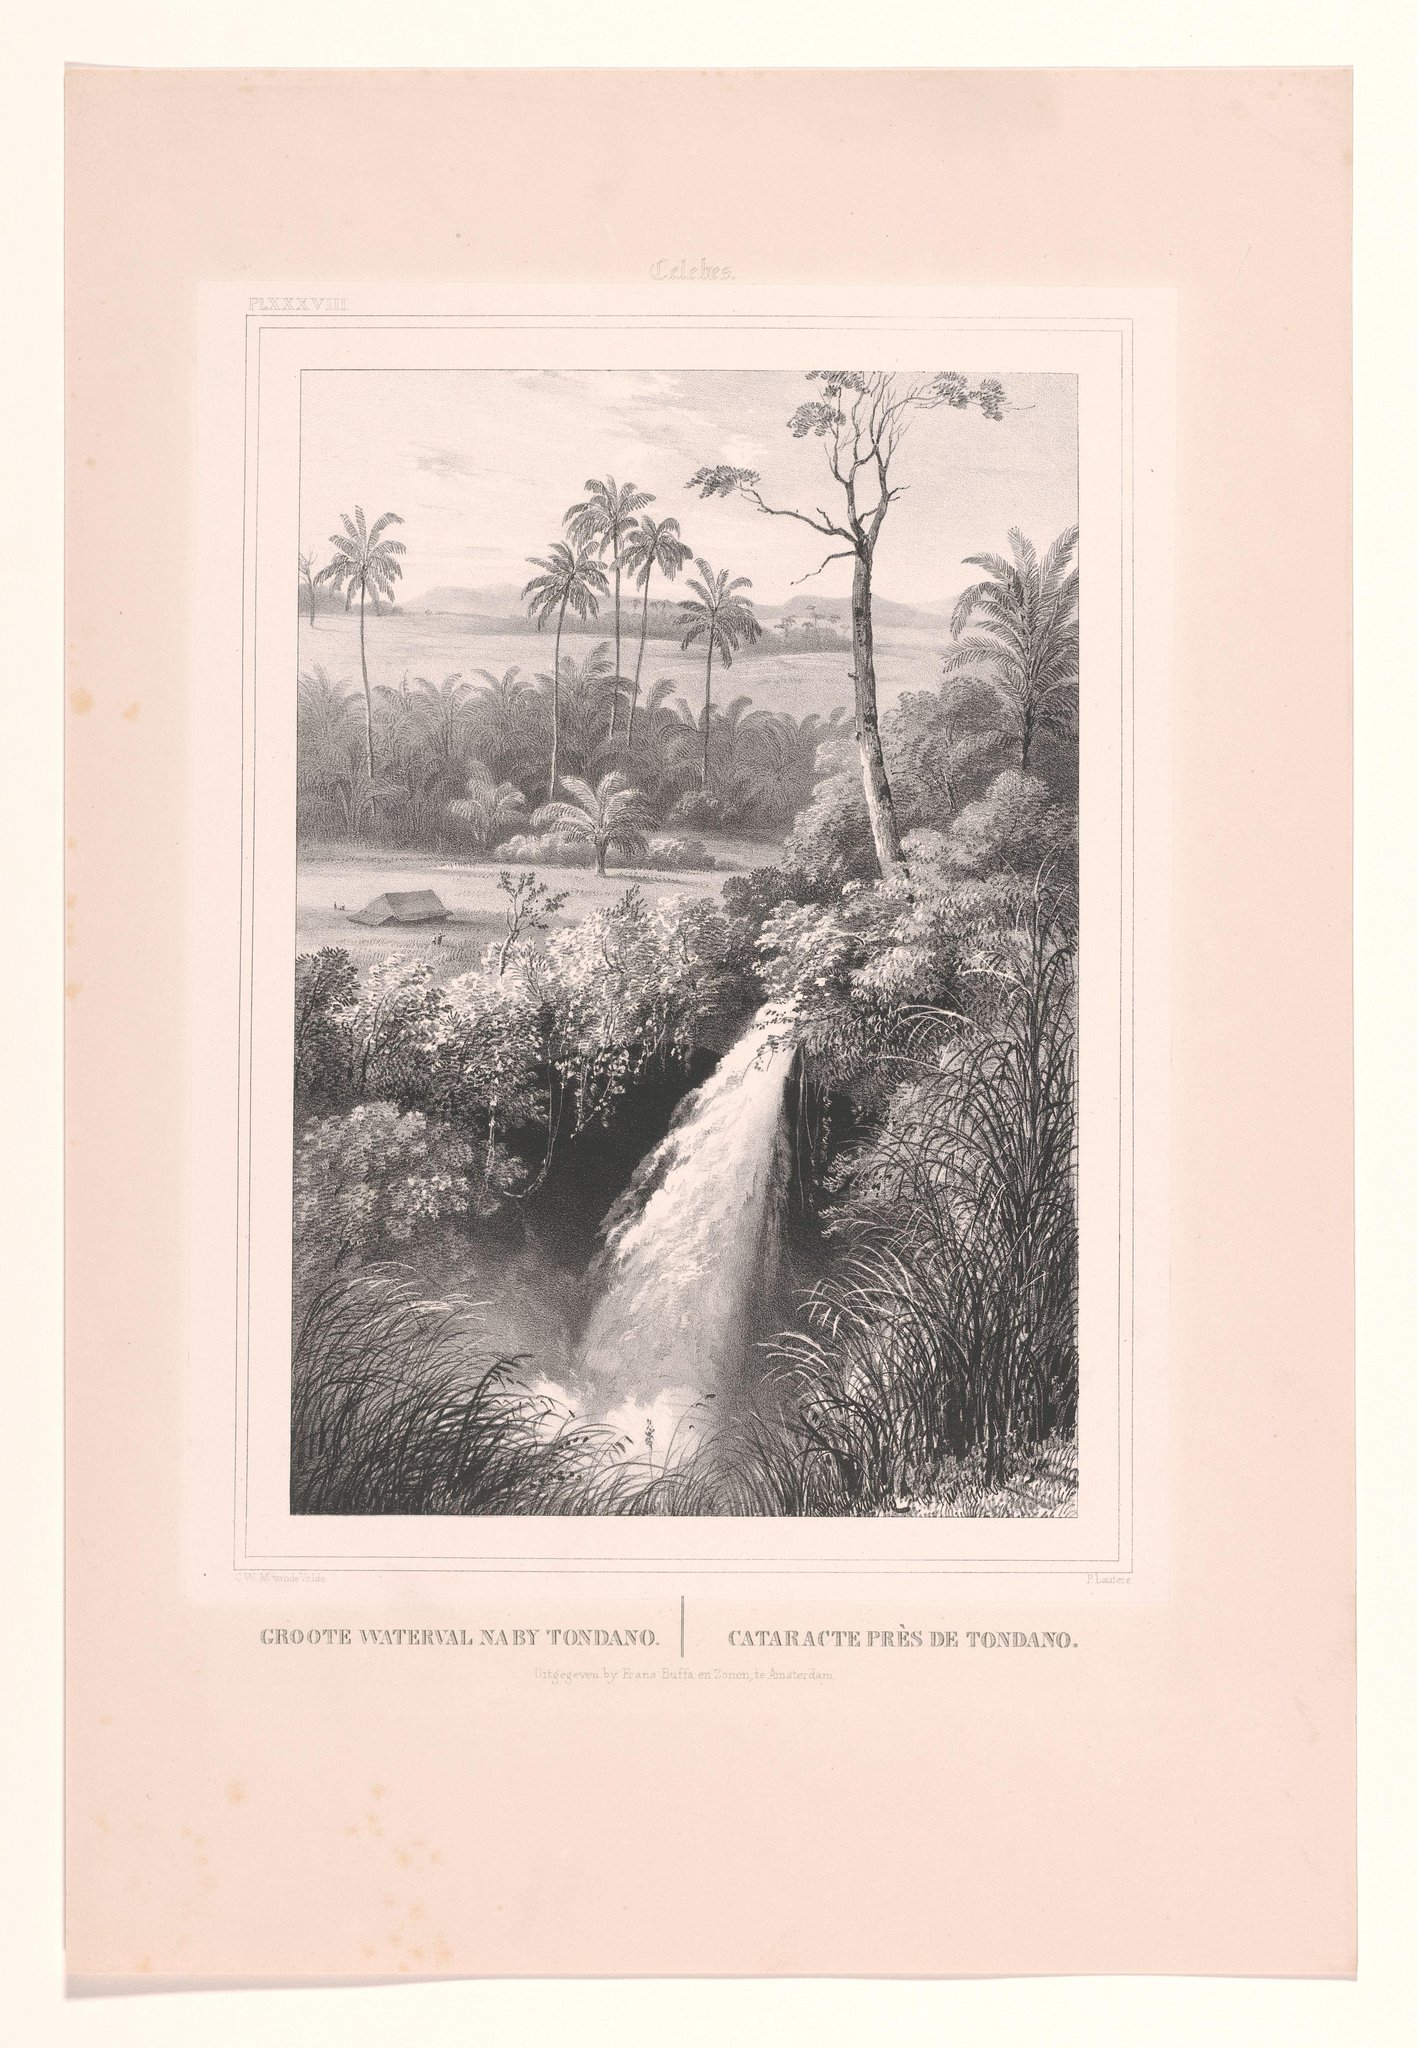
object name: print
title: Celebes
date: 1843-1845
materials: paper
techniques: lithograph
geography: indonesia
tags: waterfall, landscapes in the non-temperate zone, exotic landscapes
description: Genummerd linksboven: Pl. XXXVIII. De prent maakt deel uit van een omslag met acht bladen.